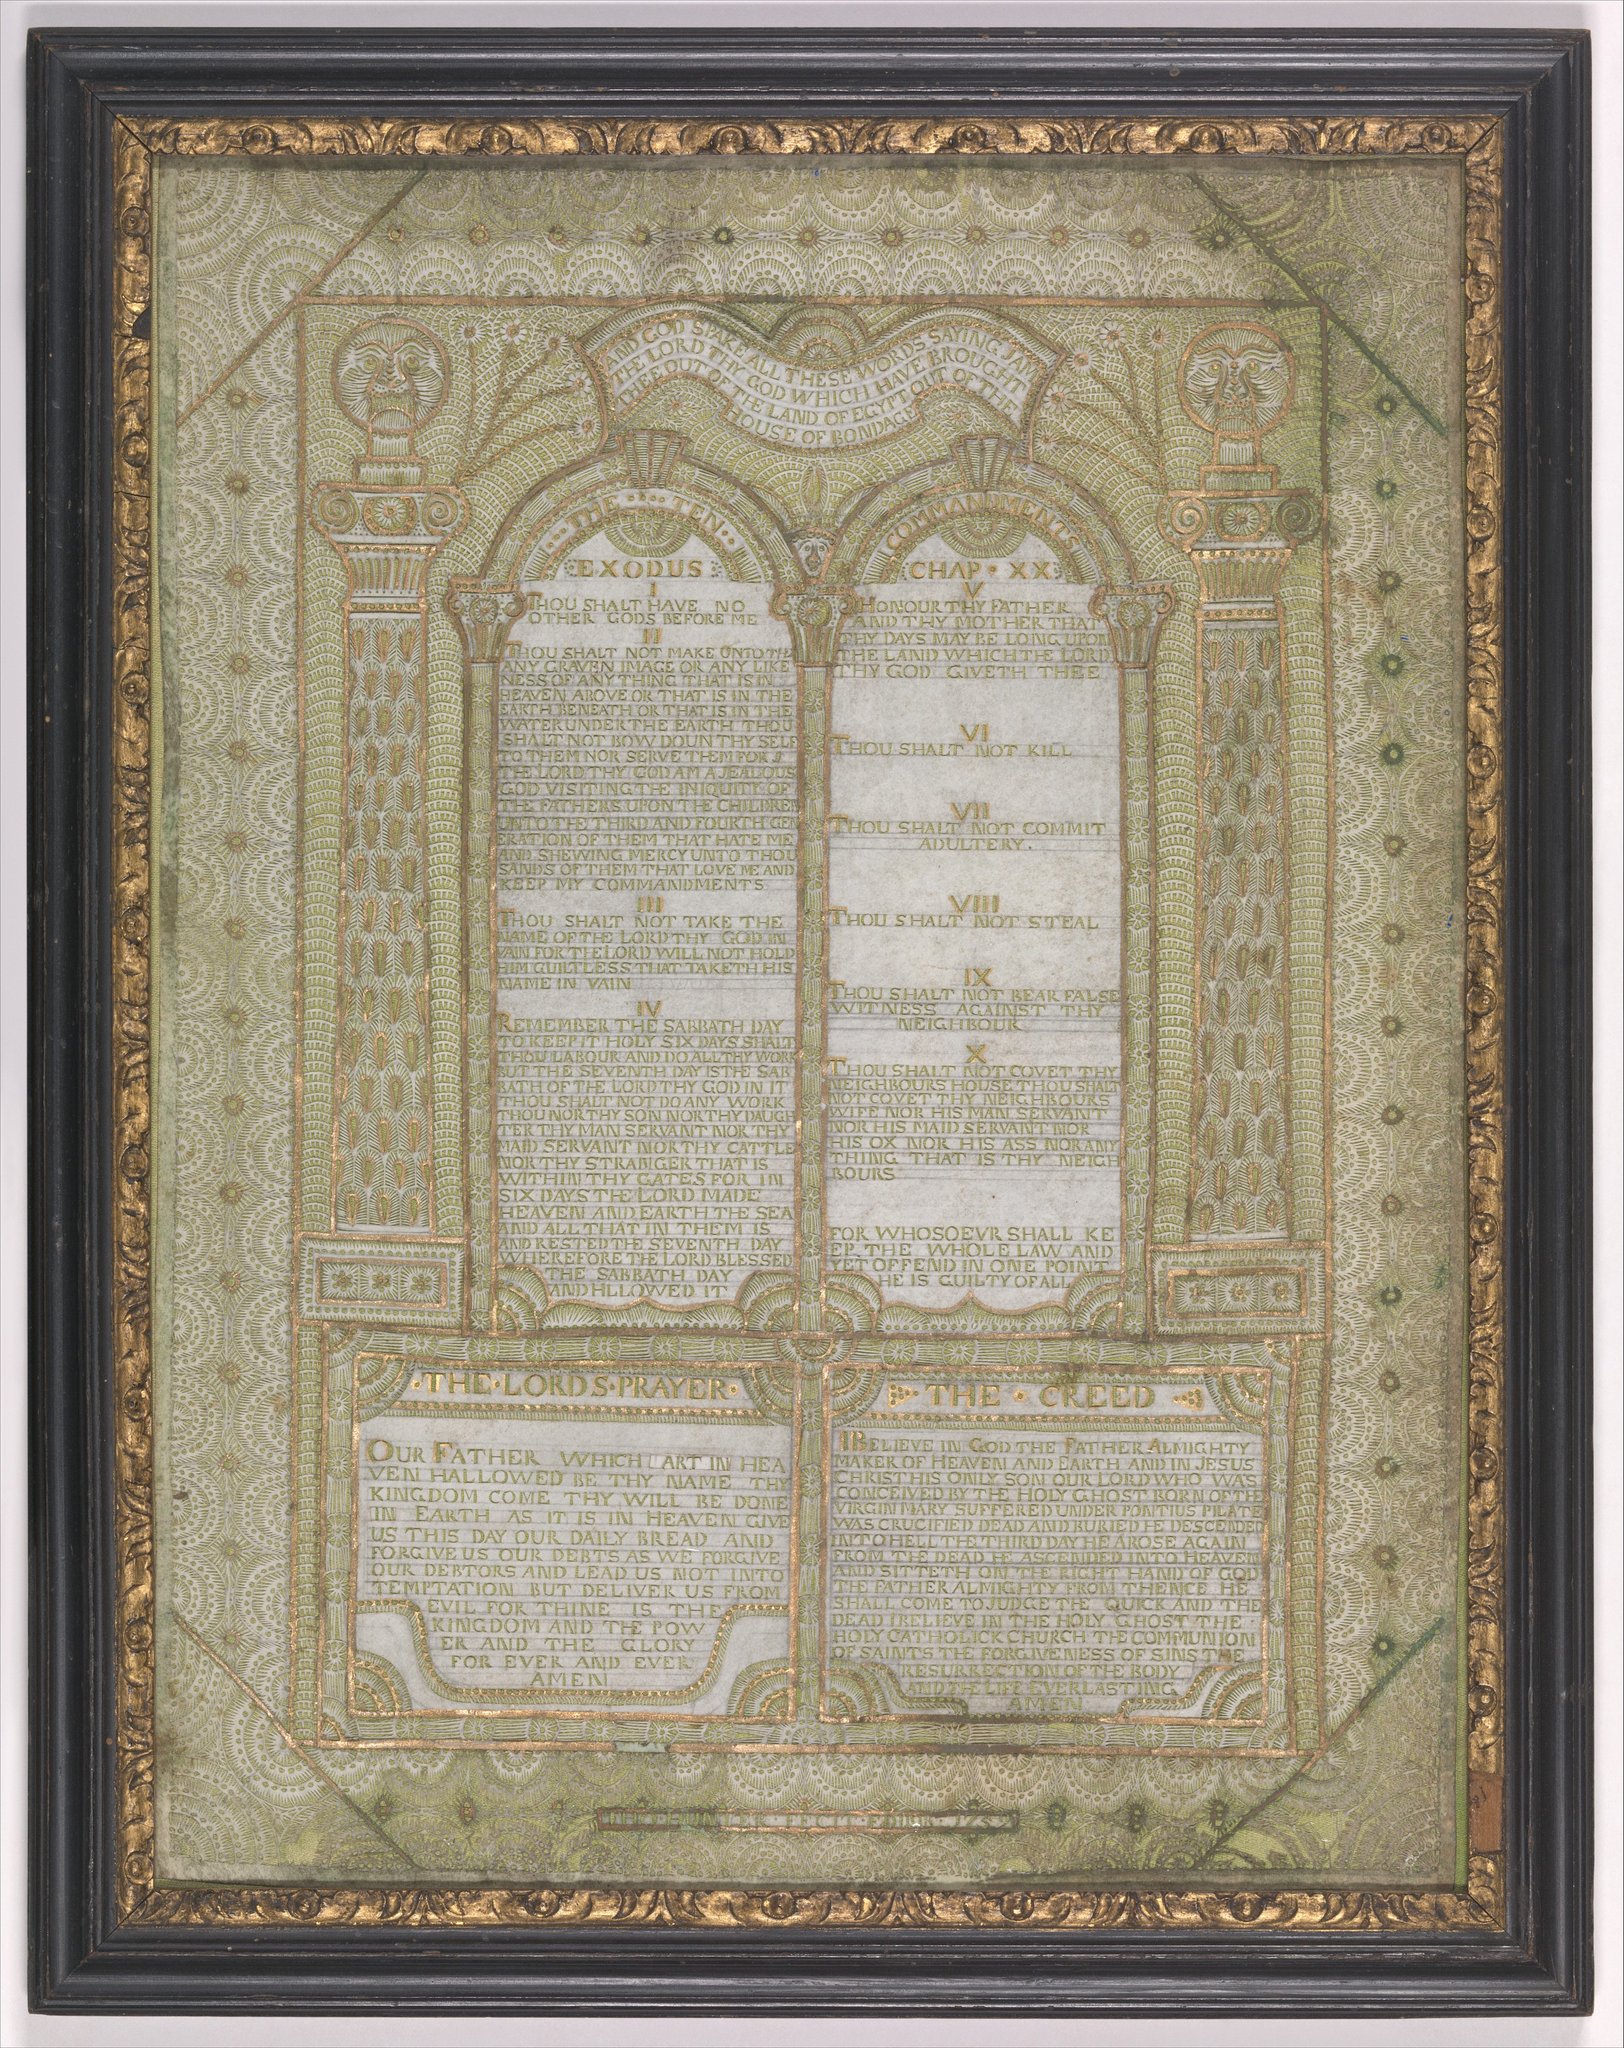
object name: cut paper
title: The Ten Commandments, The Lord's Prayer, and The Creed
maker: thomas hunter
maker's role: artist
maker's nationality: british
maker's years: 1754-1764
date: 1759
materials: silk, parchment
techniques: cutting